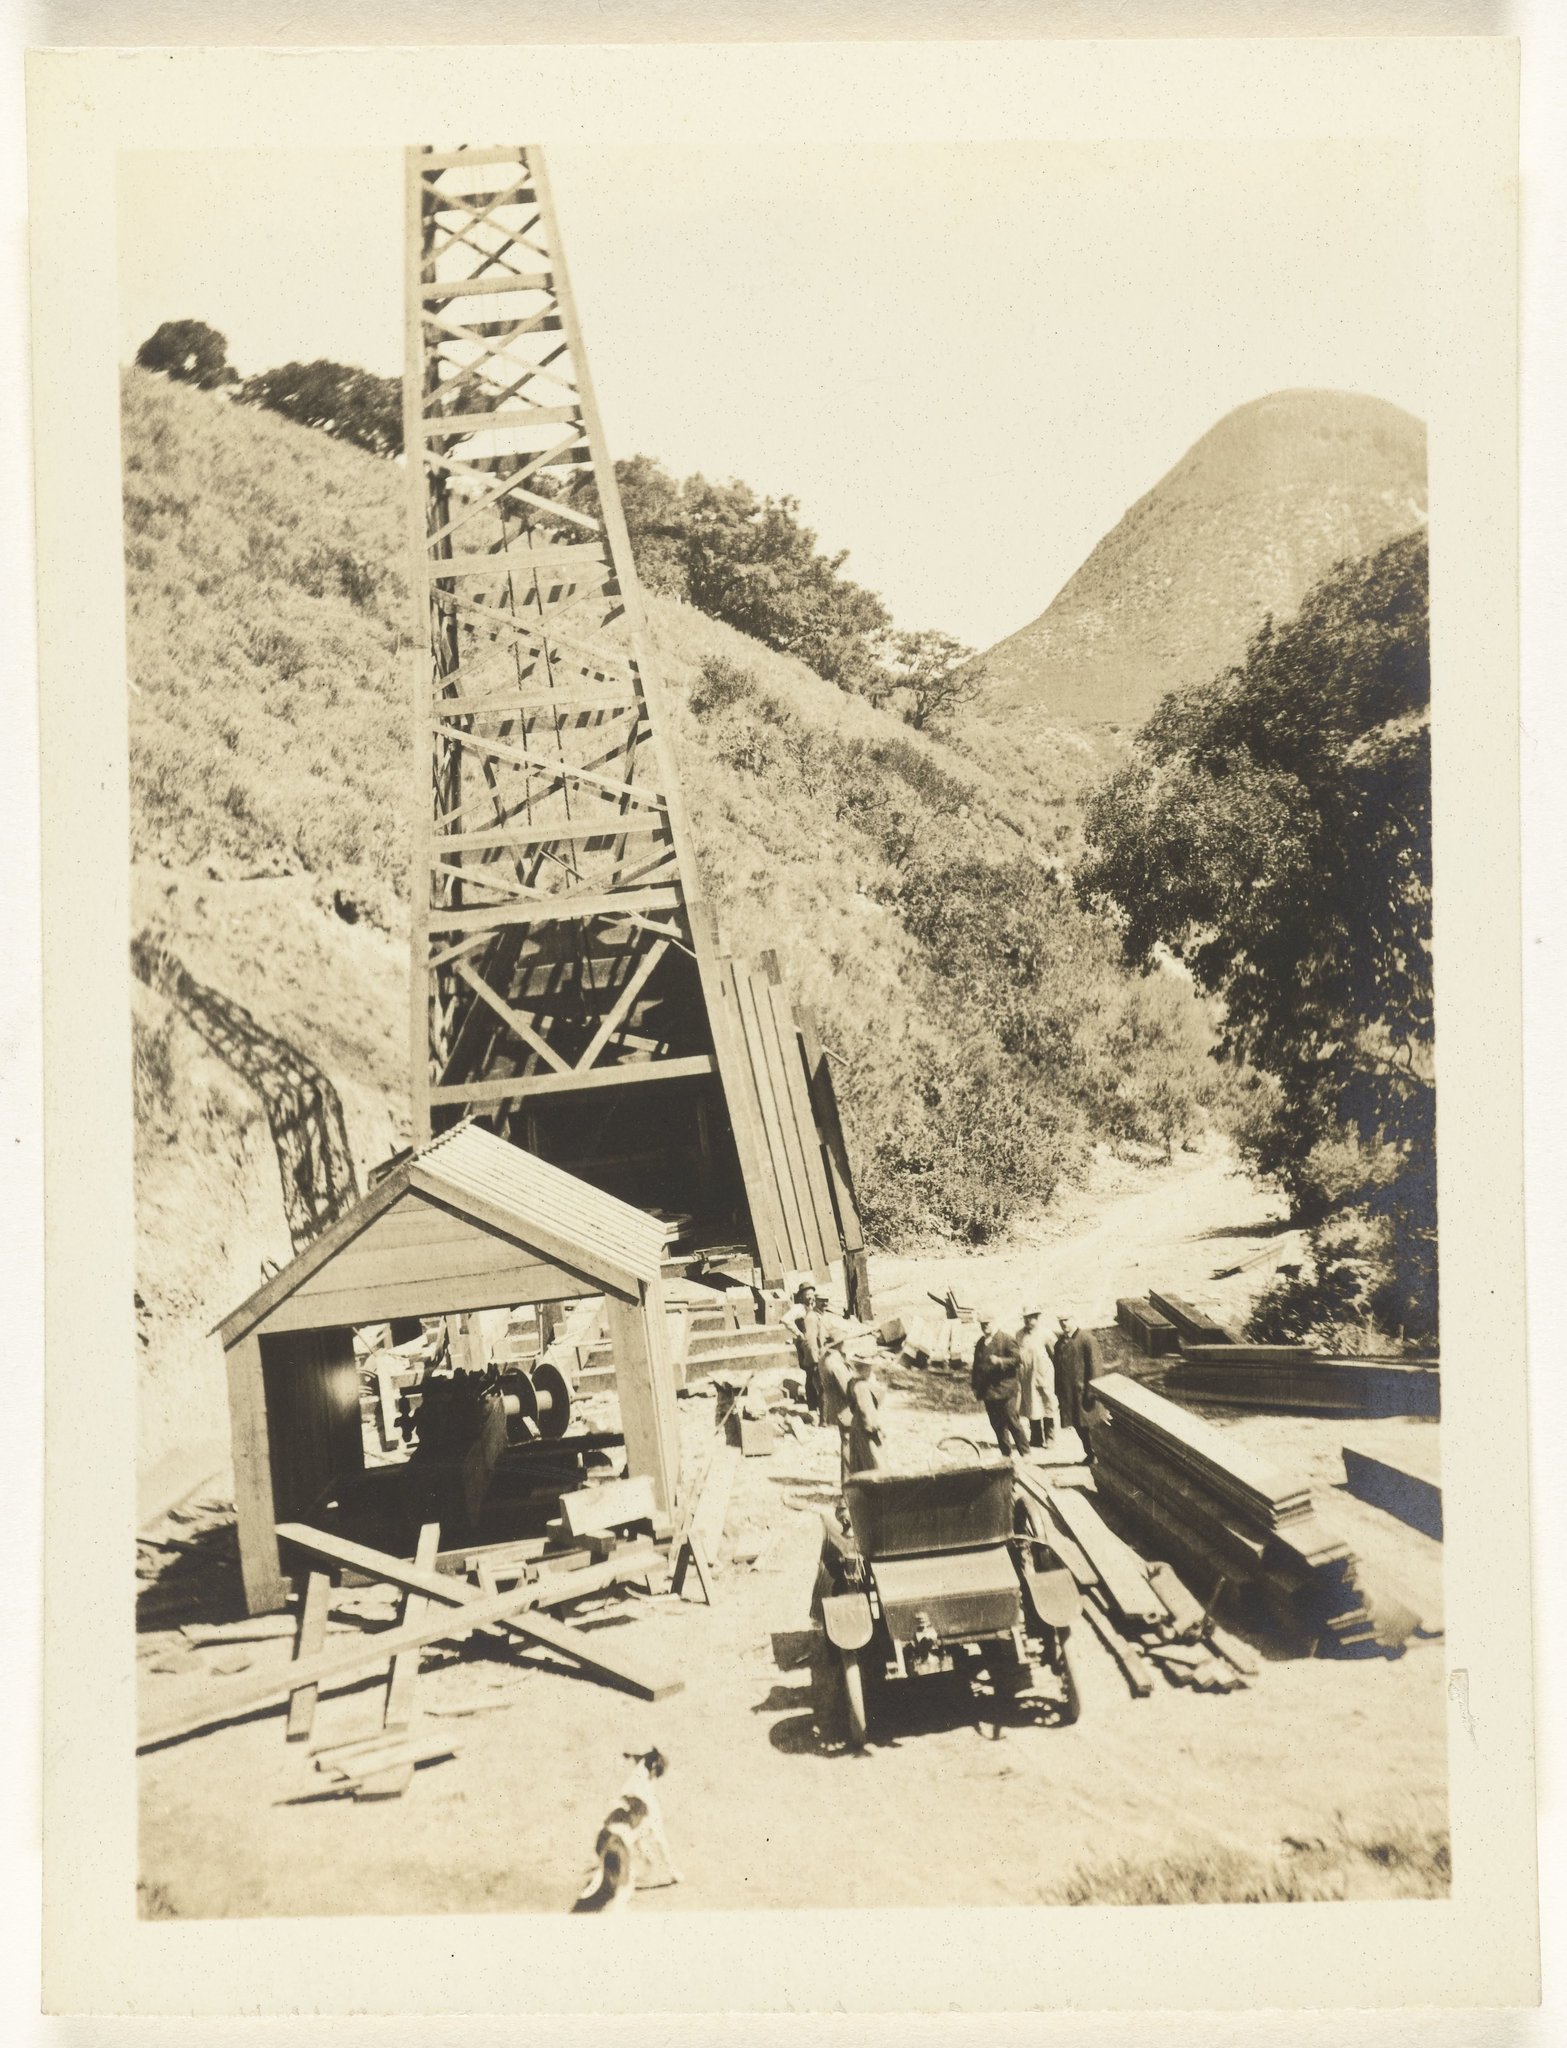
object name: photograph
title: In the Purisima hills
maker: geldolph adriaan kessler (dolph)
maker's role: fotograaf, industrieel, voetballer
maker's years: 1884-1945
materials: cardboard, photographic support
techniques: gelatin silver print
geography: california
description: Bezoek aan een olieboortoren in Purisima Hills in Zuid Californië. Onderdeel van het fotoalbum van Dolph Kessler met opnamen die hij maakte tijdens zijn verblijf in Engeland en op een wereldreis die hij als secretaris van Henri Deterding (directeur Koninklijke Olie) ondernam naar Nederlands-Indië, Japan, China en de Verenigde Staten, tussen 1906 en 1908.